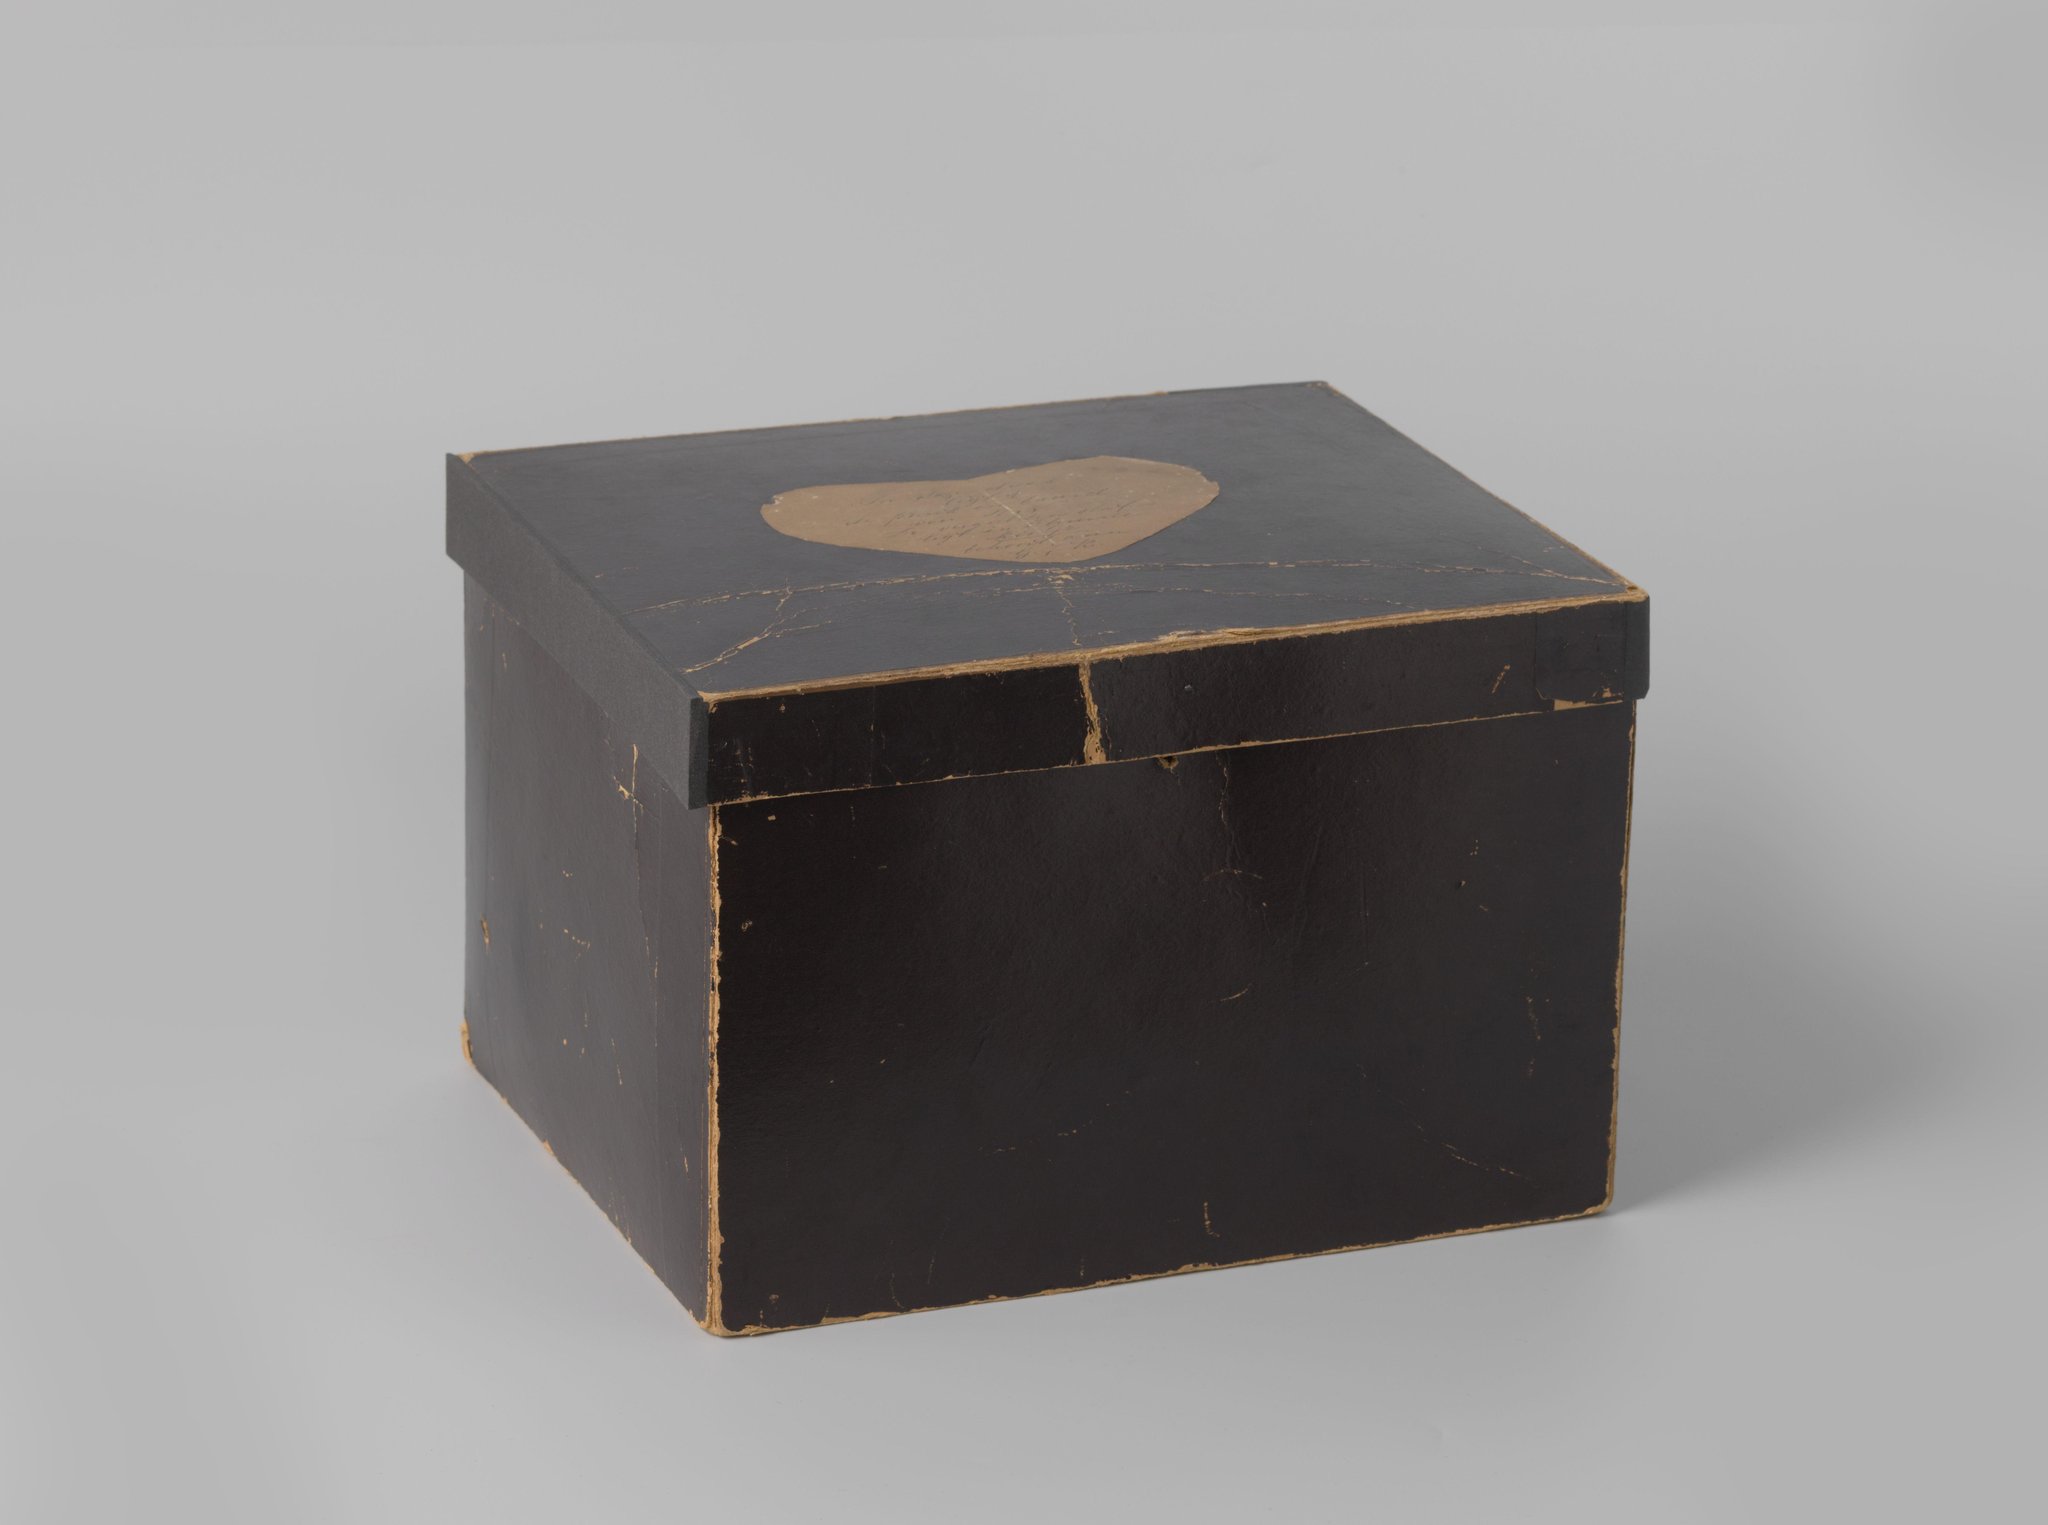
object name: packing material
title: Doos met deksel van karton met zwart papier beplakt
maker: Anonymous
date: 1840-1900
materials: cardboard, paper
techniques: pasting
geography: europe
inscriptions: label: ‘In deze doos / ligt: / de pruik en baard / voor St. N. / De vergulden staf / ligt in t' bruine / kistje / behoort aan / G. J. K.’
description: Bij de Japonsche rock werd een doos met de volgende inhoud gegeven: zijden jasje, roodfluwelen slippers met zilverdraad geborduurd, een masker en een mijter van papier en een staf. Tezamen vormden deze objecten een Sinterklaas-kostuum dat in de 19de eeuw ten huize van familie van de schenkster werd gedragen:' ca. 1875 voor nichtjes van mijn moeder gebruikt. Alles komt uit de familie van mijn overgrootmoeder Krusemann-Stavorinus.'